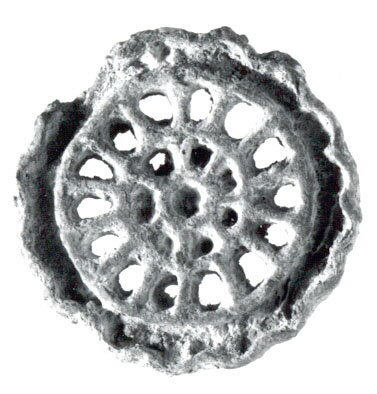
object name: stamp seal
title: Compartmented stamp seal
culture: bactria-margiana archaeological complex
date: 2333-1668 BCE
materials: copper alloy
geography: bactria-margiana